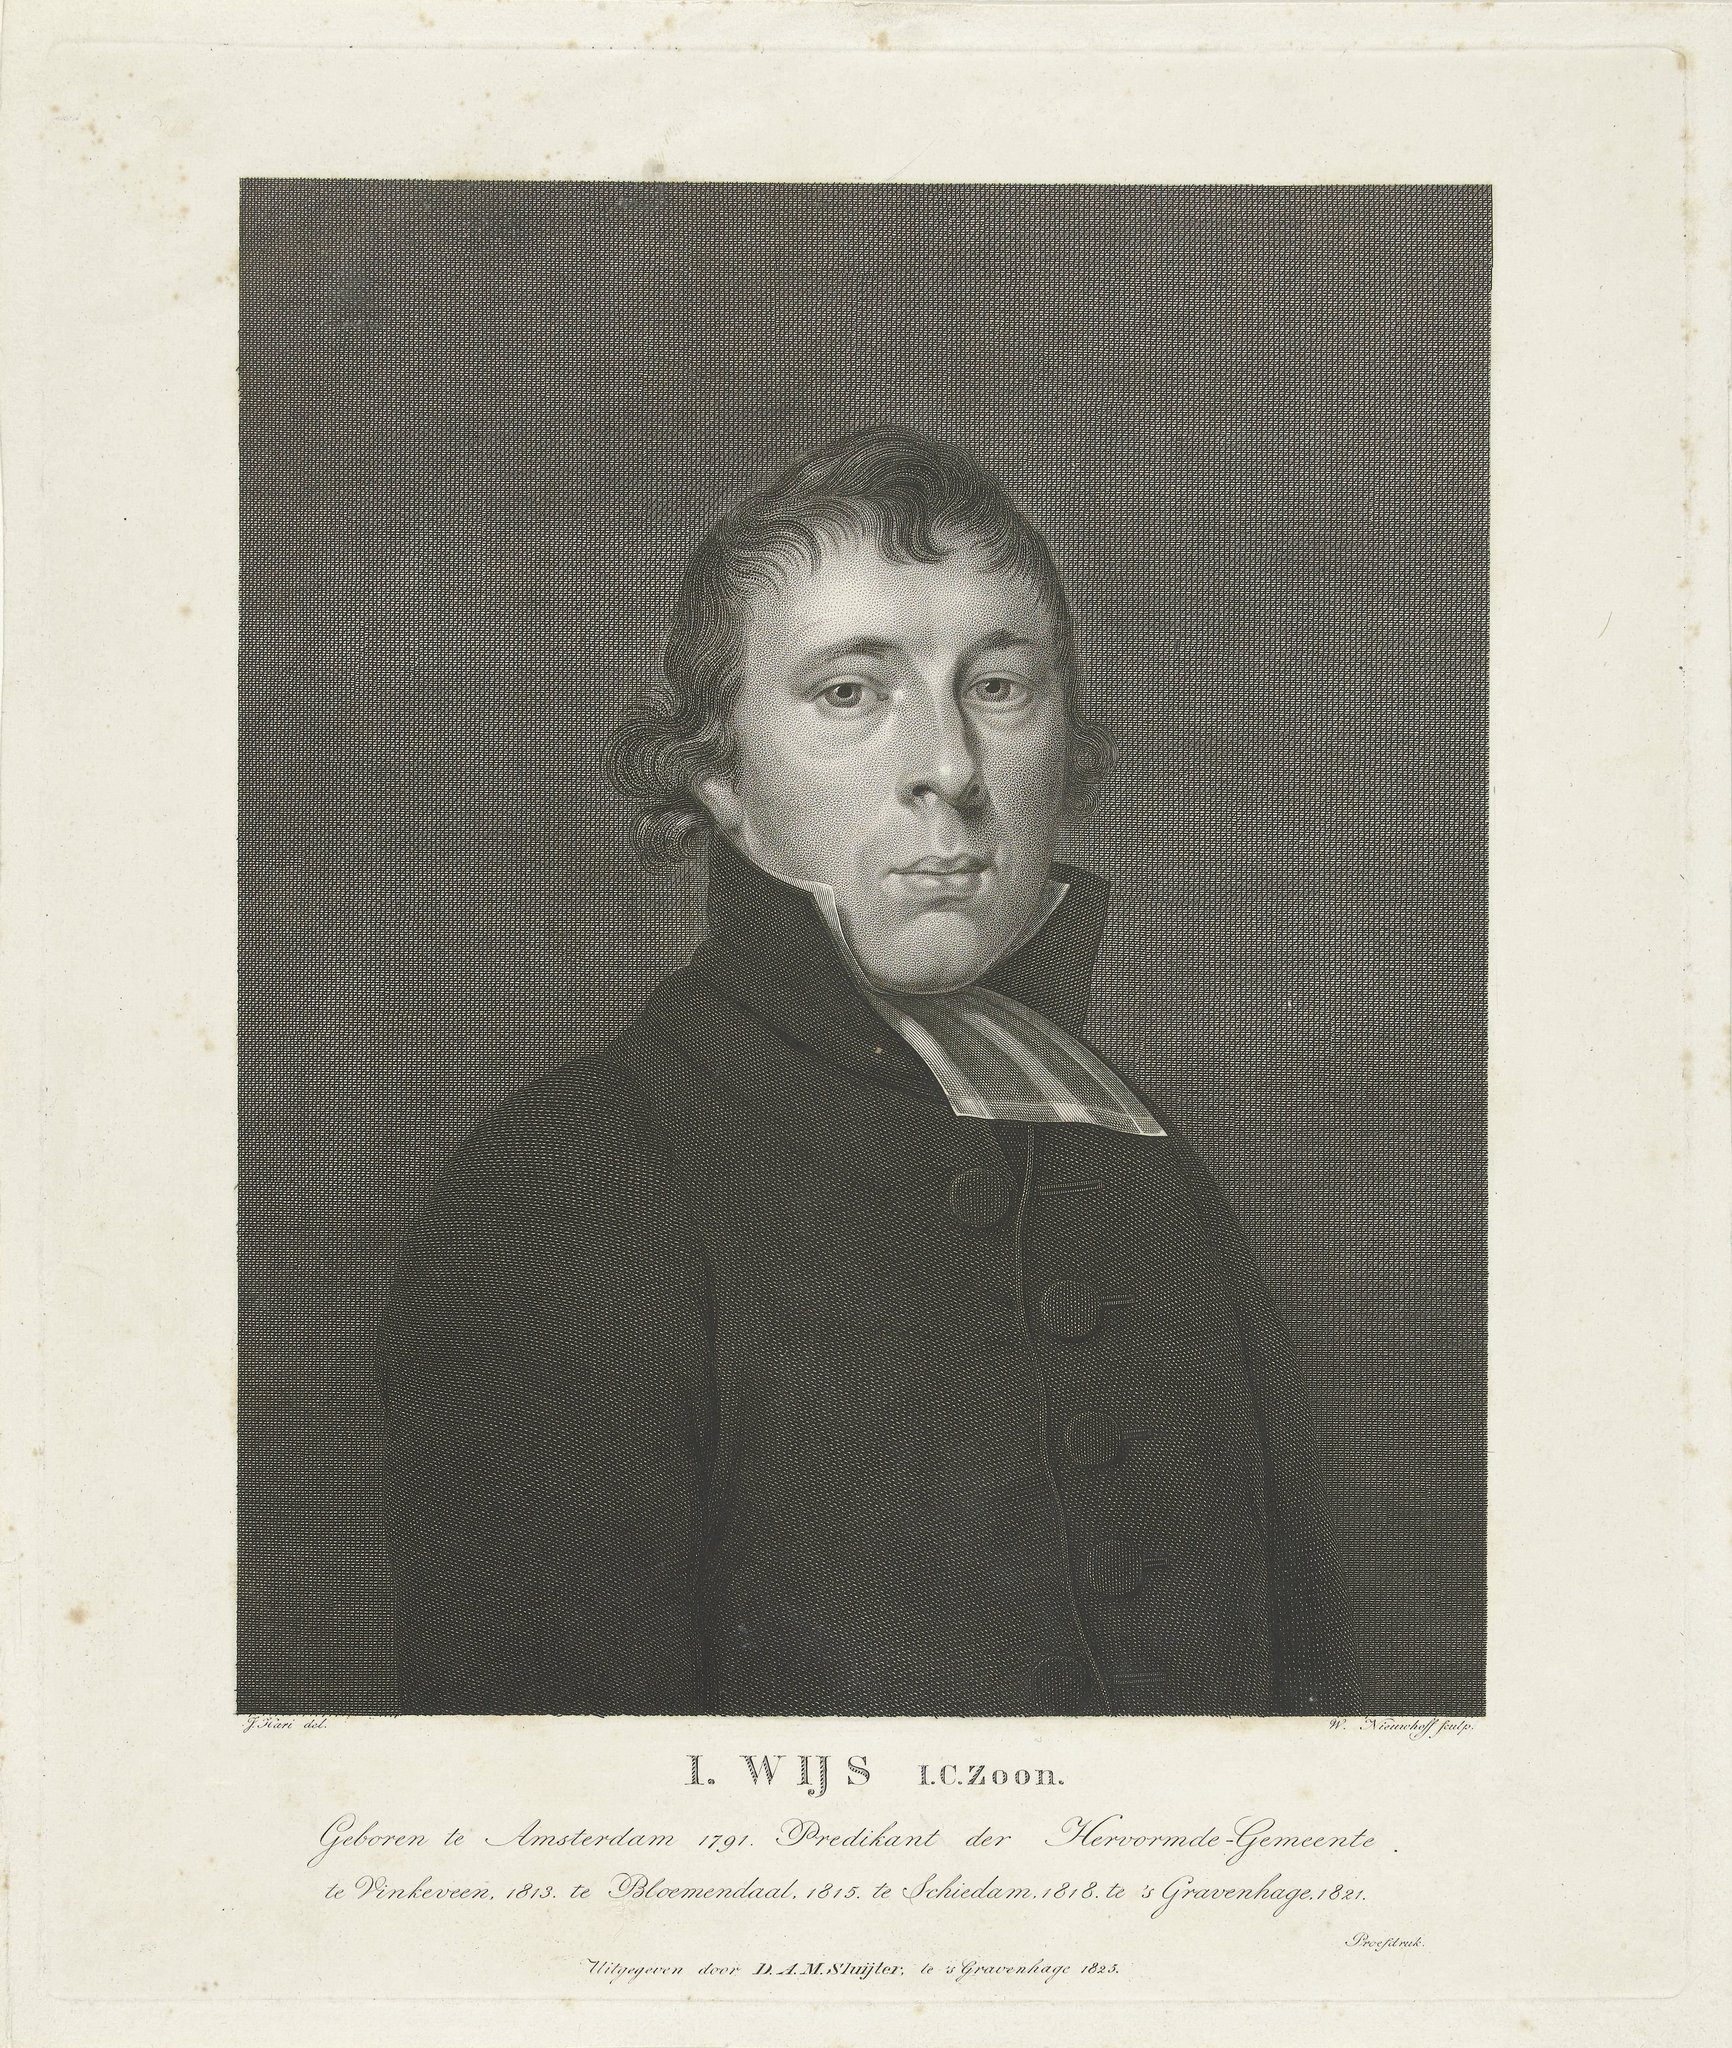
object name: print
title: Portret van Jacob Wijs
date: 1825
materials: paper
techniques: engraving, etching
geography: the hague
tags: predikant, jacob wijs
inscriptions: collector's mark: Lugt 2228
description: Buste van Jacob Wijs, hervormd predikant te Den Haag, naar rechts. Onderaan in de marge een tweeregelige tekst in het Nederlands.